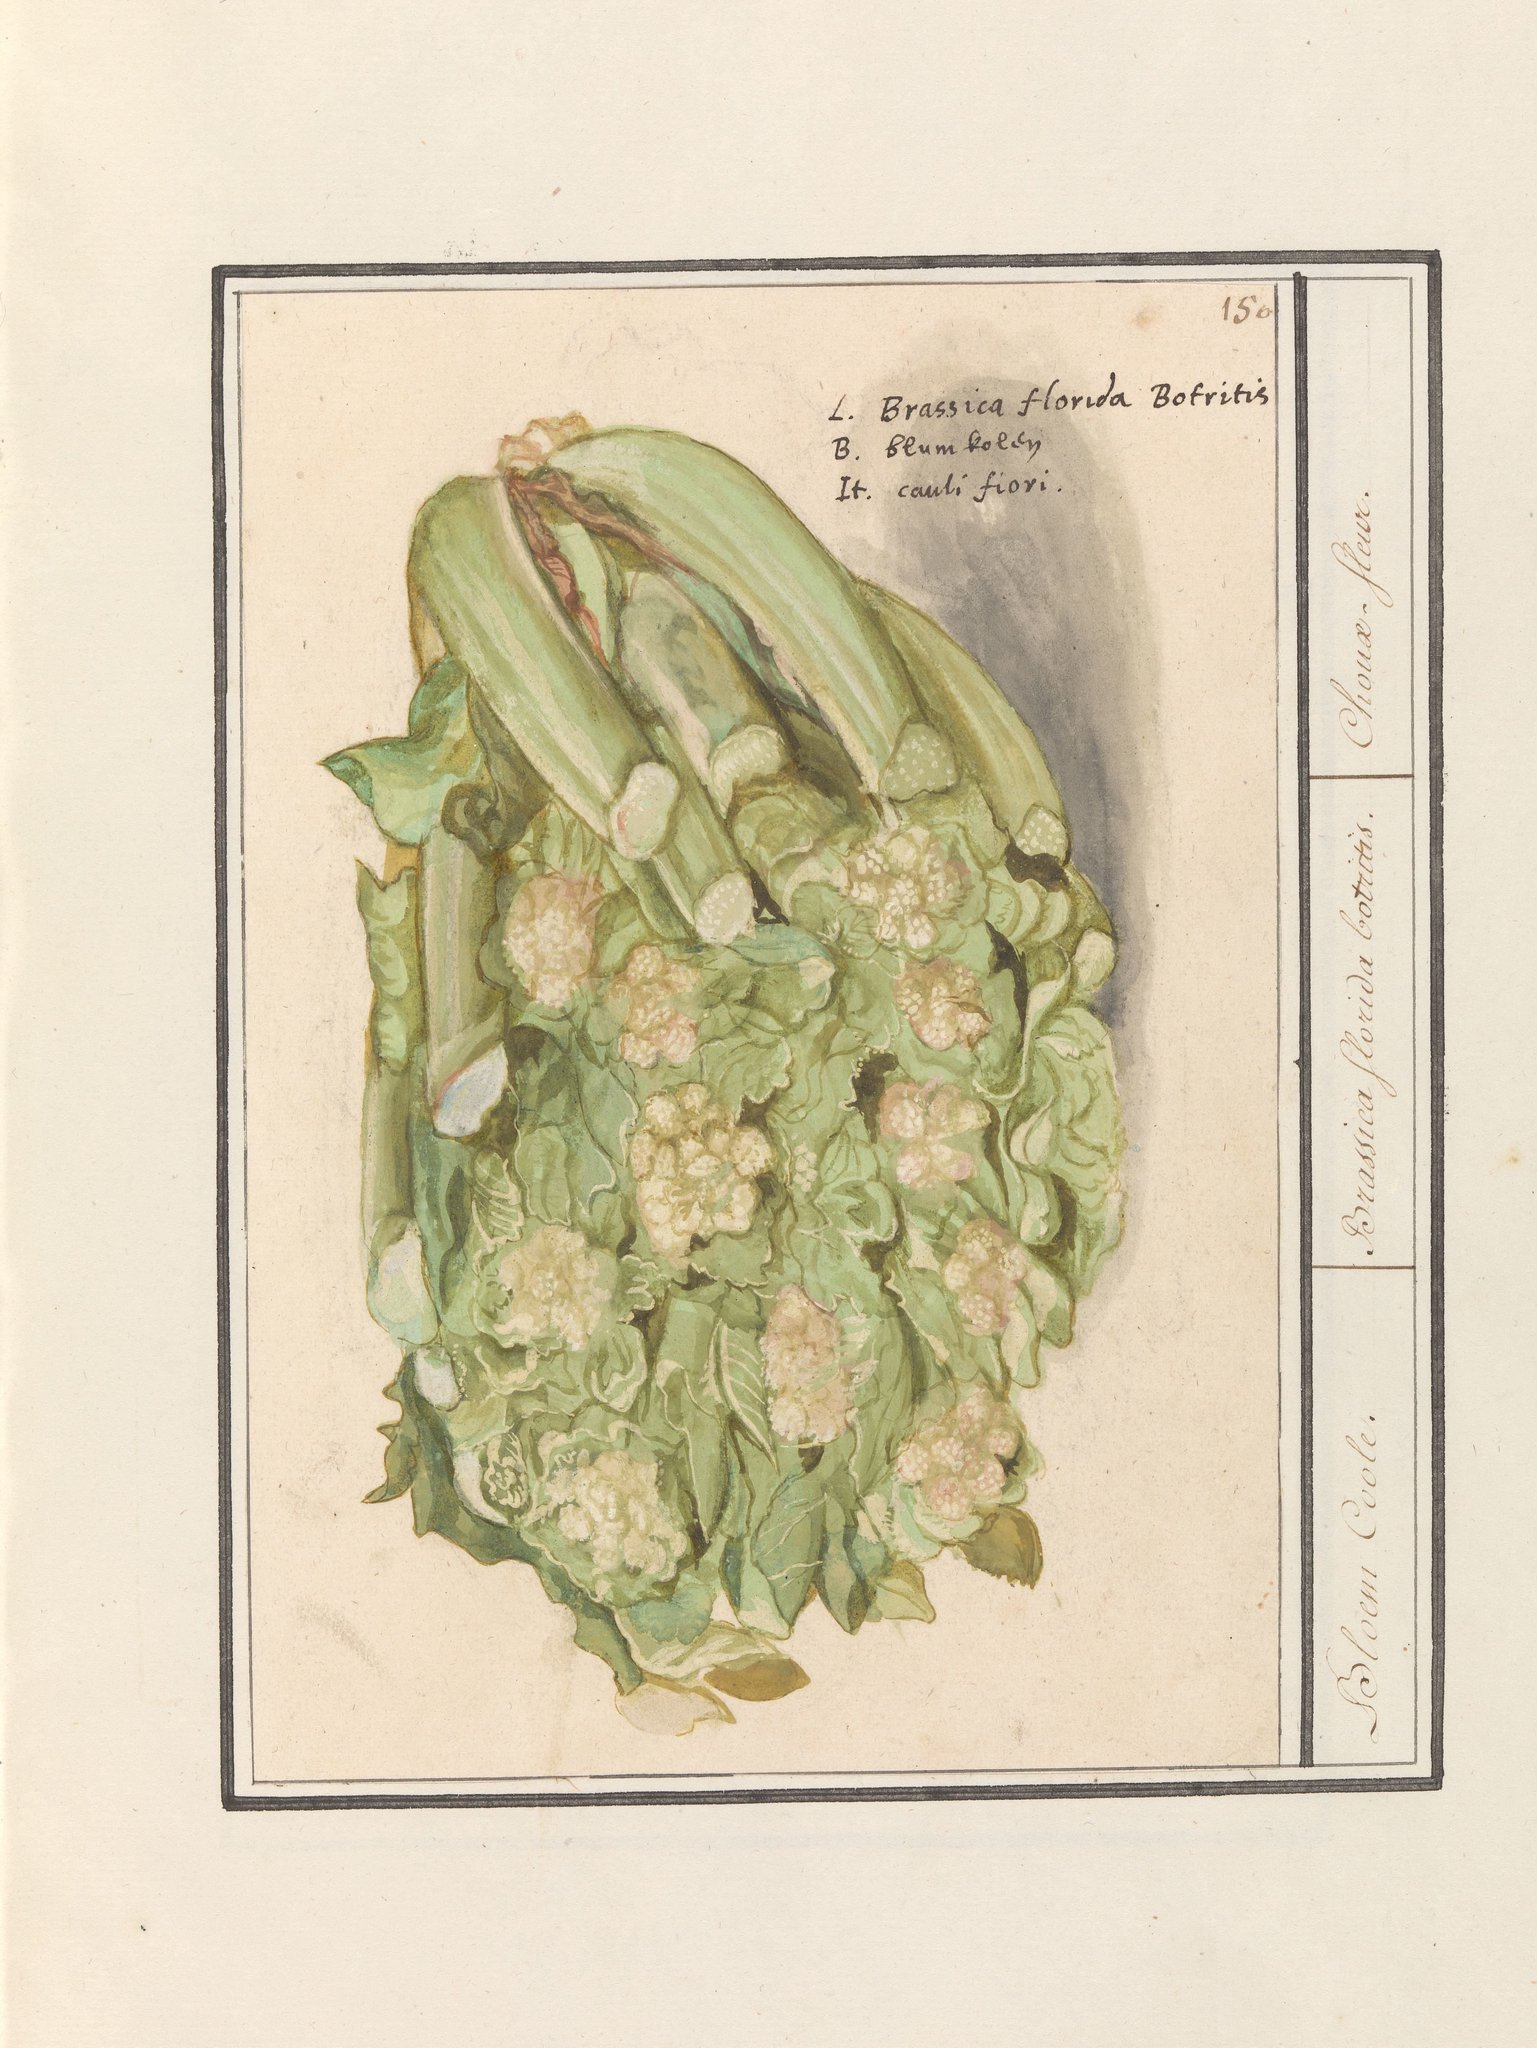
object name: drawing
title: Cauliflower (Brassica oleracea convar. botrytis var. Botrytis)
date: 1596-1610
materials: chalk, paint, ink, paper, watercolor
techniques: brush, pen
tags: plants and herbs: cauliflower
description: That the Historia Naturalis albums were sold only three times in four centuries accounts for the excellent condition of the individual watercolours. The green leaves and white florets of the cauliflower still look incredibly fresh. The draughtsman successfully rendered the structure of the vegetable by using green and brown watercolour and some white highlights.